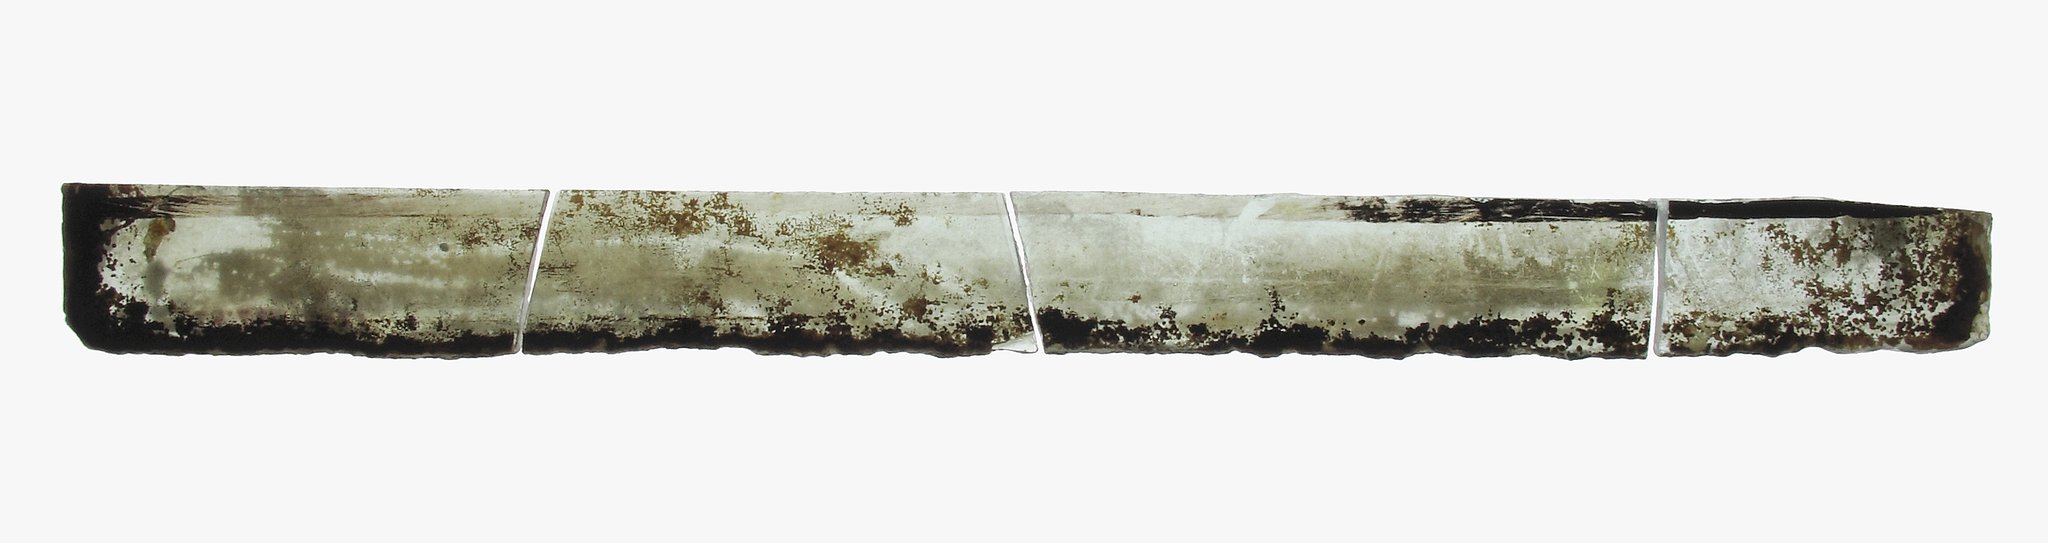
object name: fragment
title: Glass Fragment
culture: french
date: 1501-1600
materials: glass